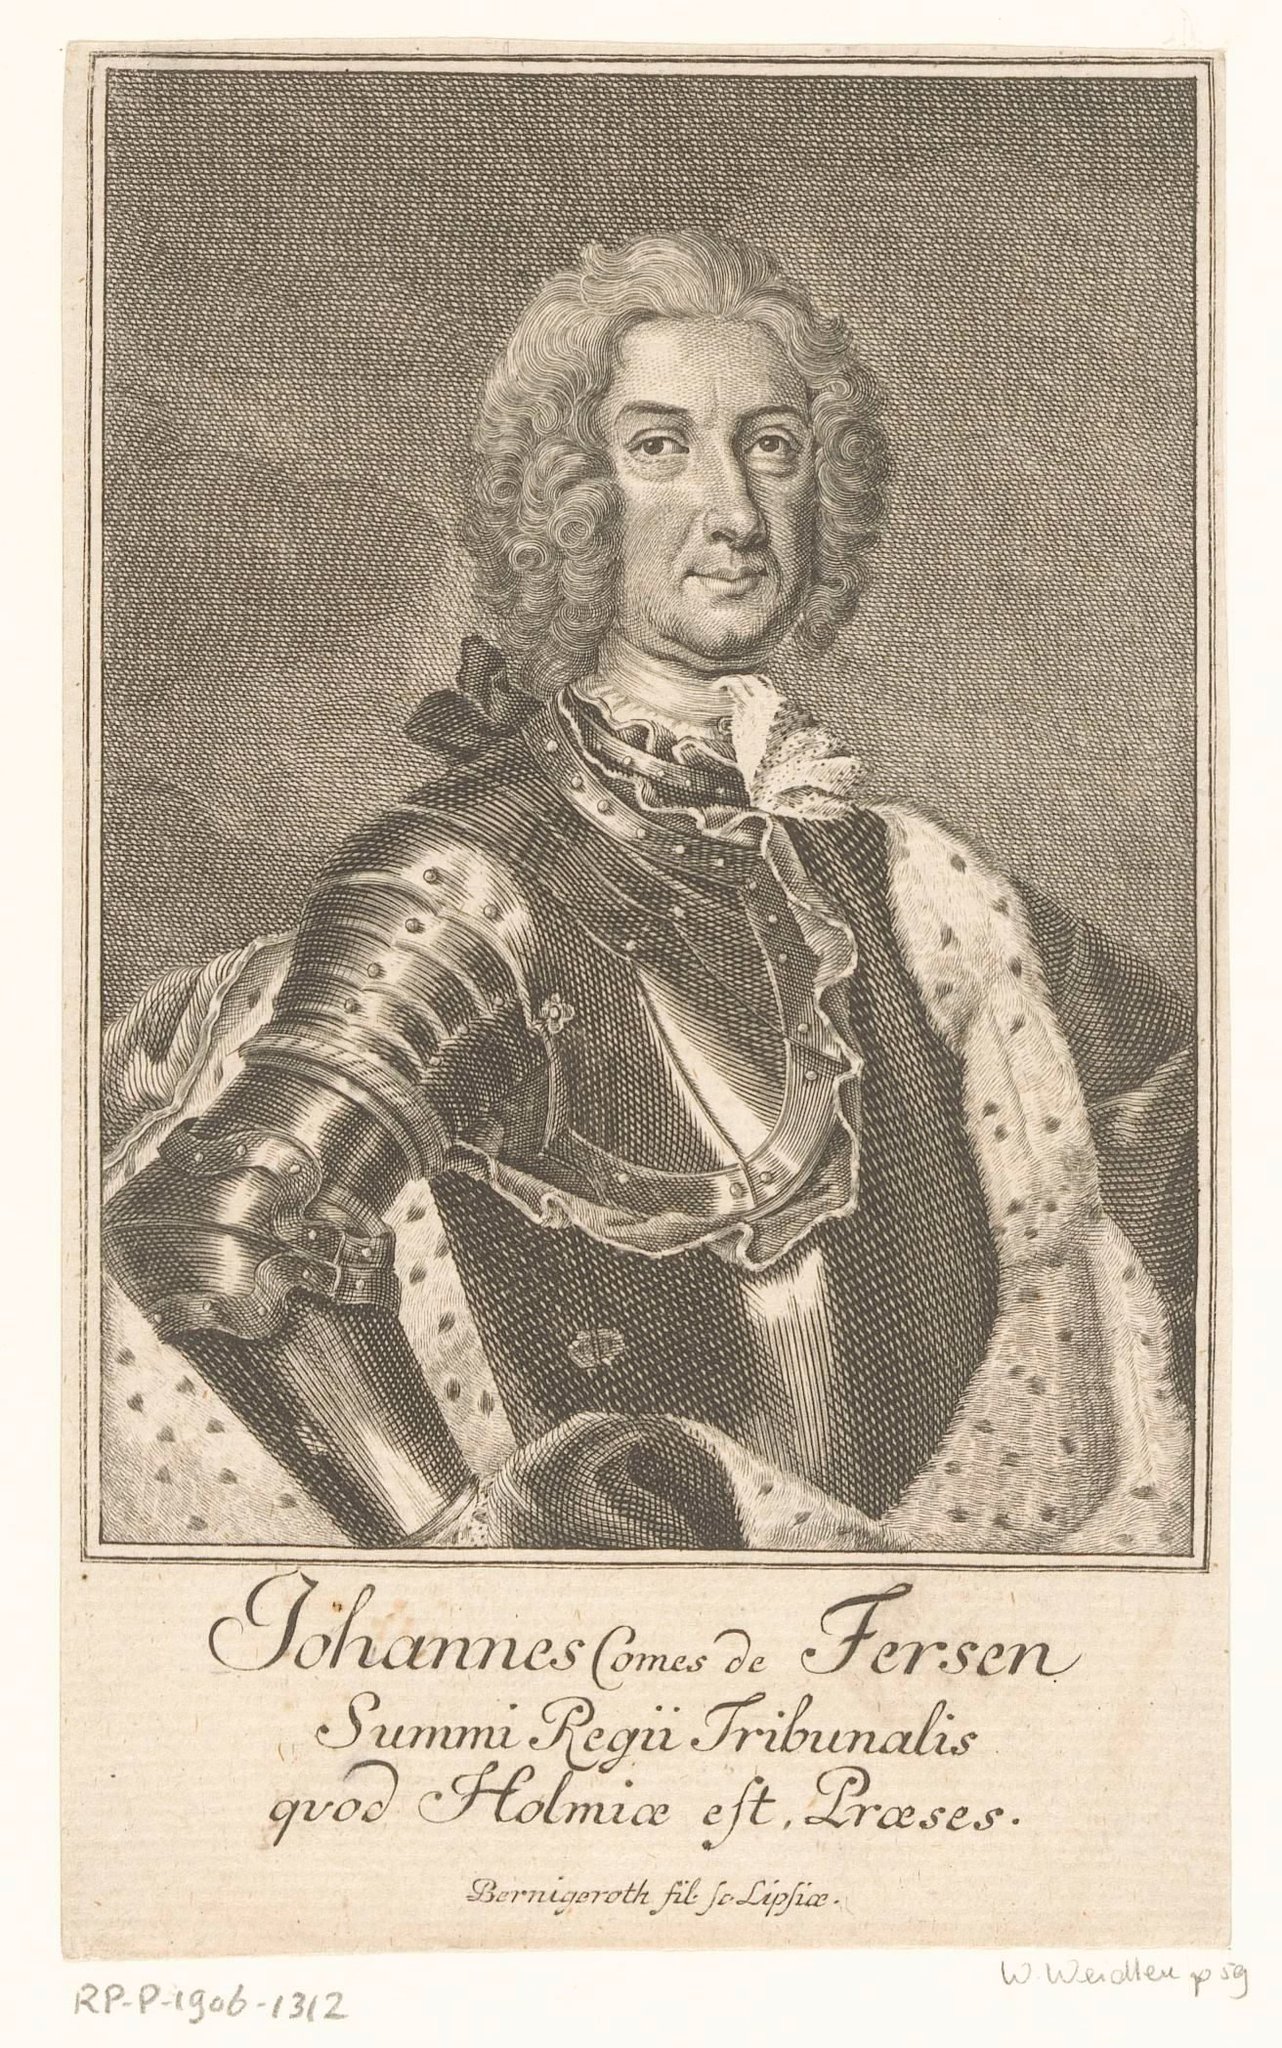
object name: print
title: Portret van Hans von Fersen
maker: johann martin bernigeroth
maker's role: print maker, publisher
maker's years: 1713-1767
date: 1737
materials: paper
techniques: engraving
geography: leipzig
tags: armour, historical persons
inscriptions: collector's mark: Lugt 2228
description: Prent ook gebruikt in: Die Neue Europäische Fama, Welche den gegenwärtigen Zustand der vornehmsten Höfe entdecket. dl. 24. Leipzig: Gleditsch, 1737.